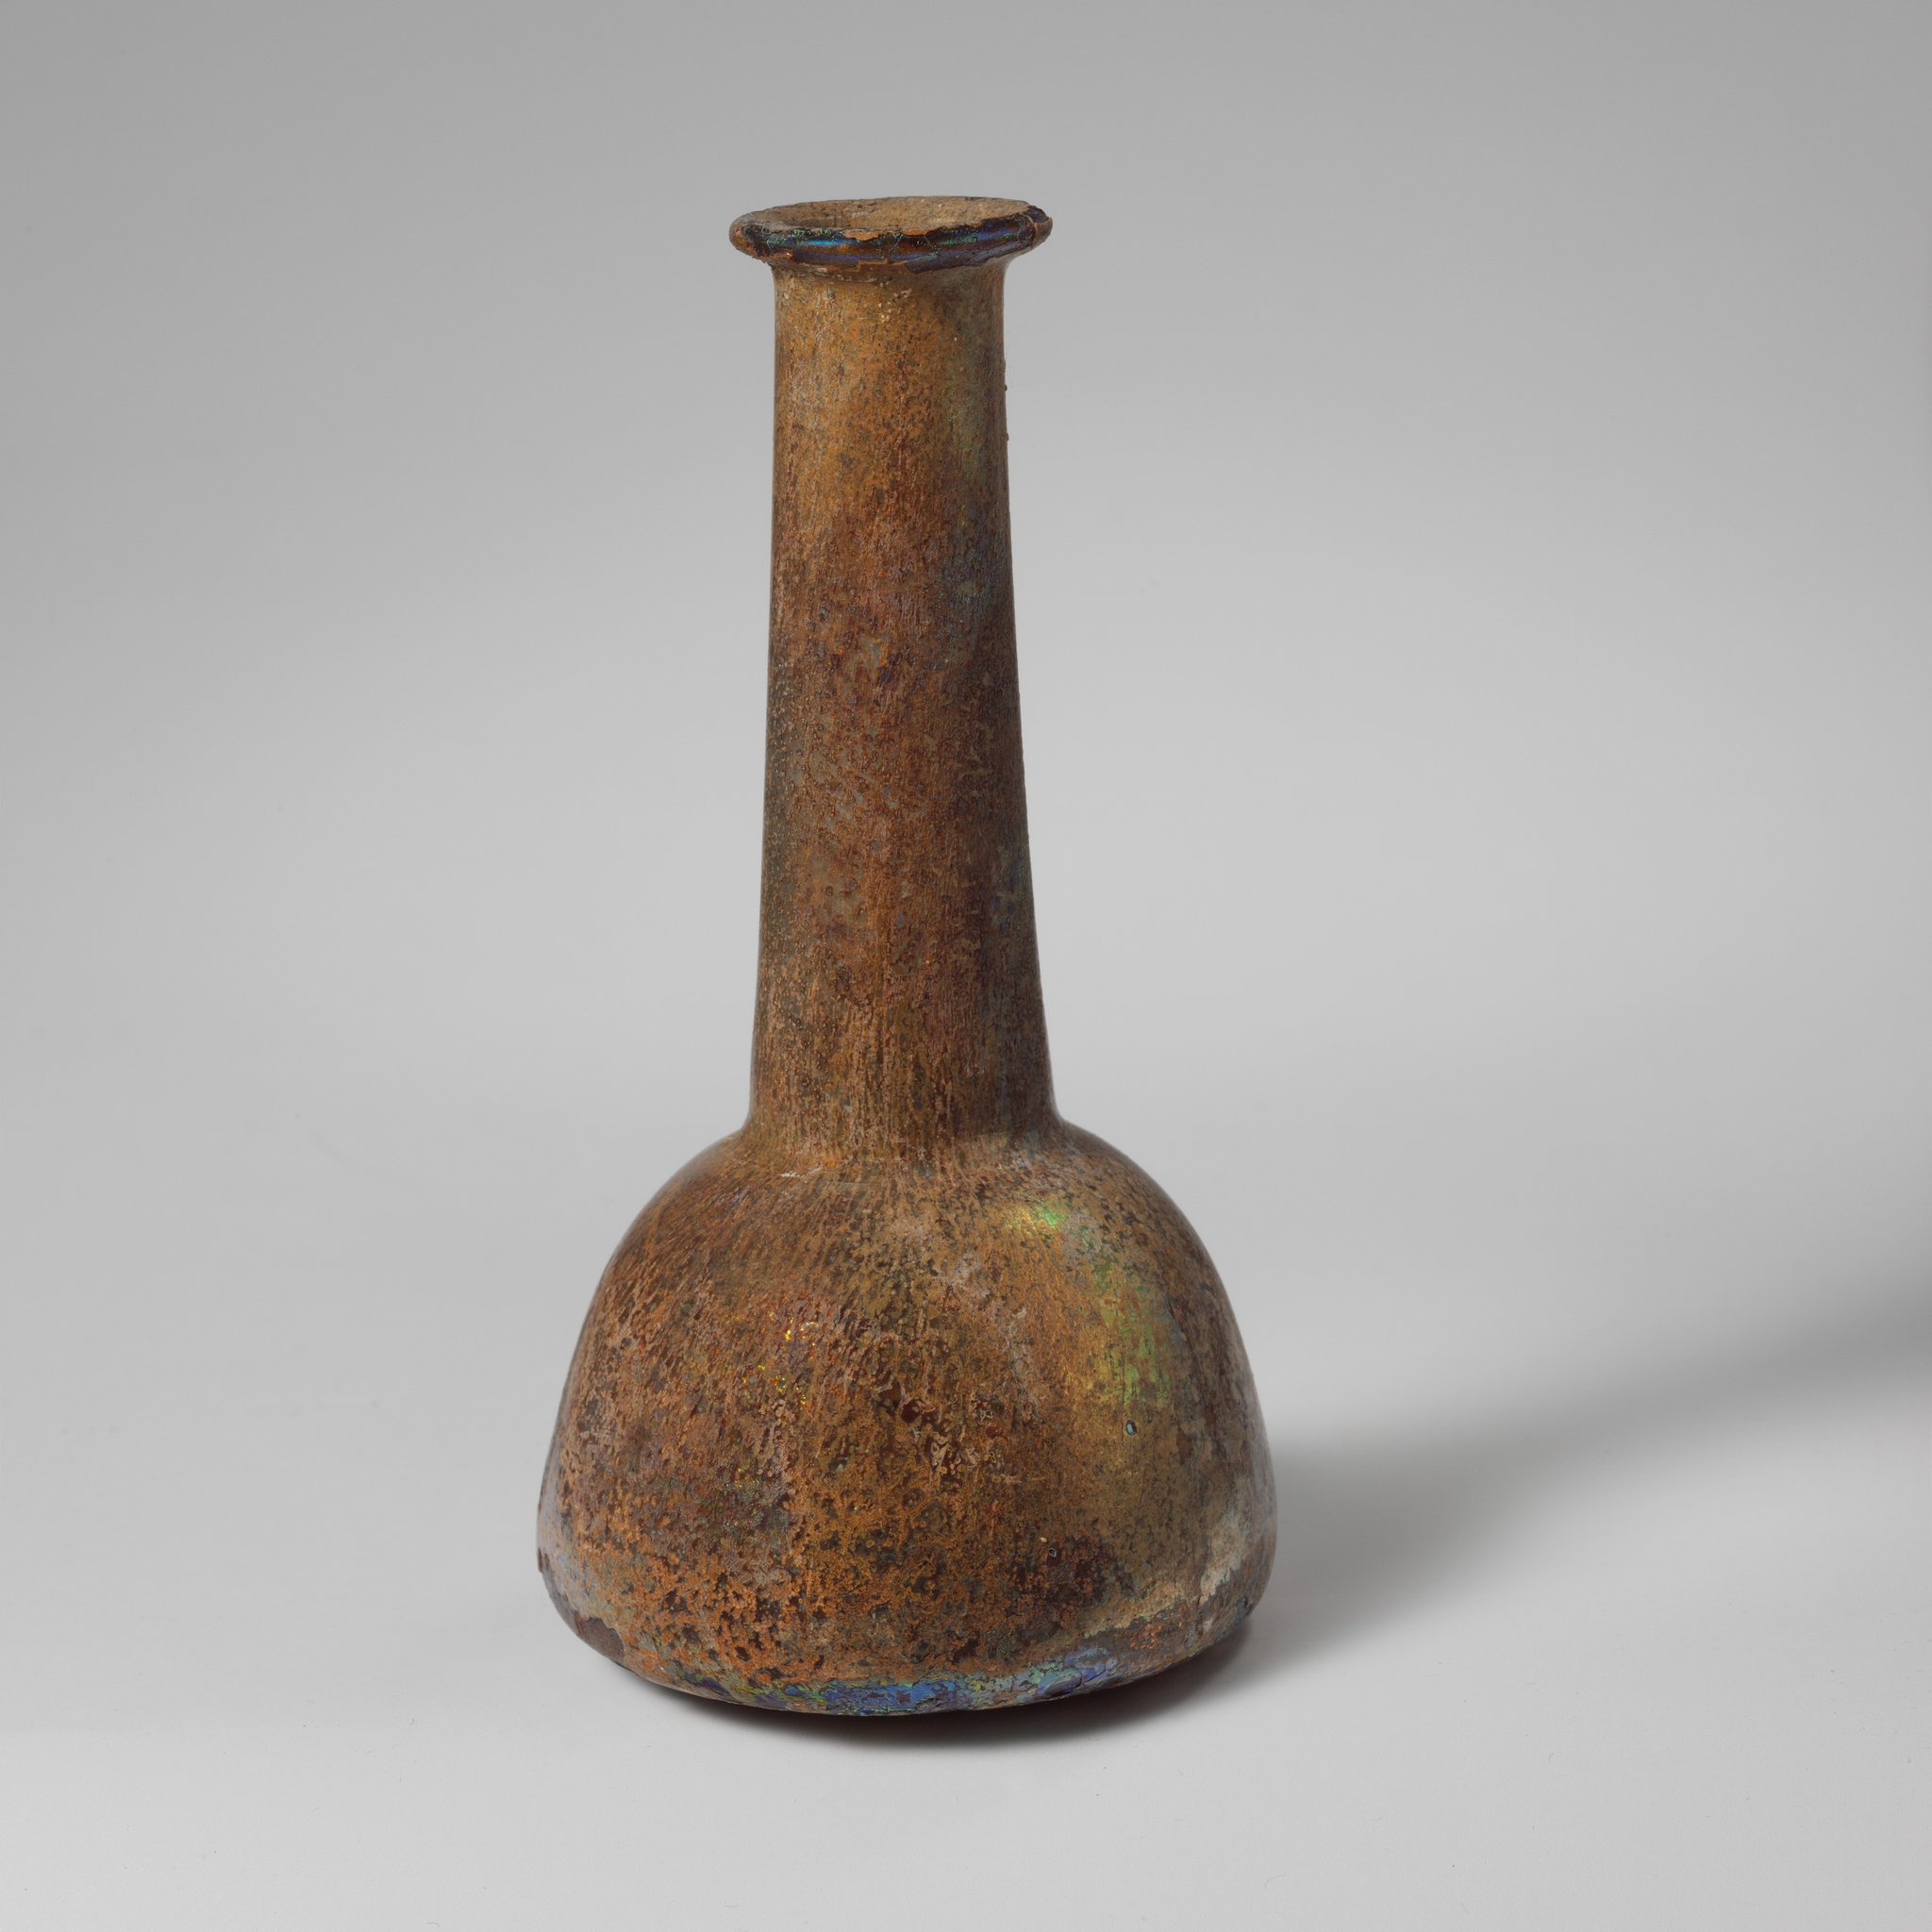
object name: perfume bottle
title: Glass perfume bottle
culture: roman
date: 101-300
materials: glass